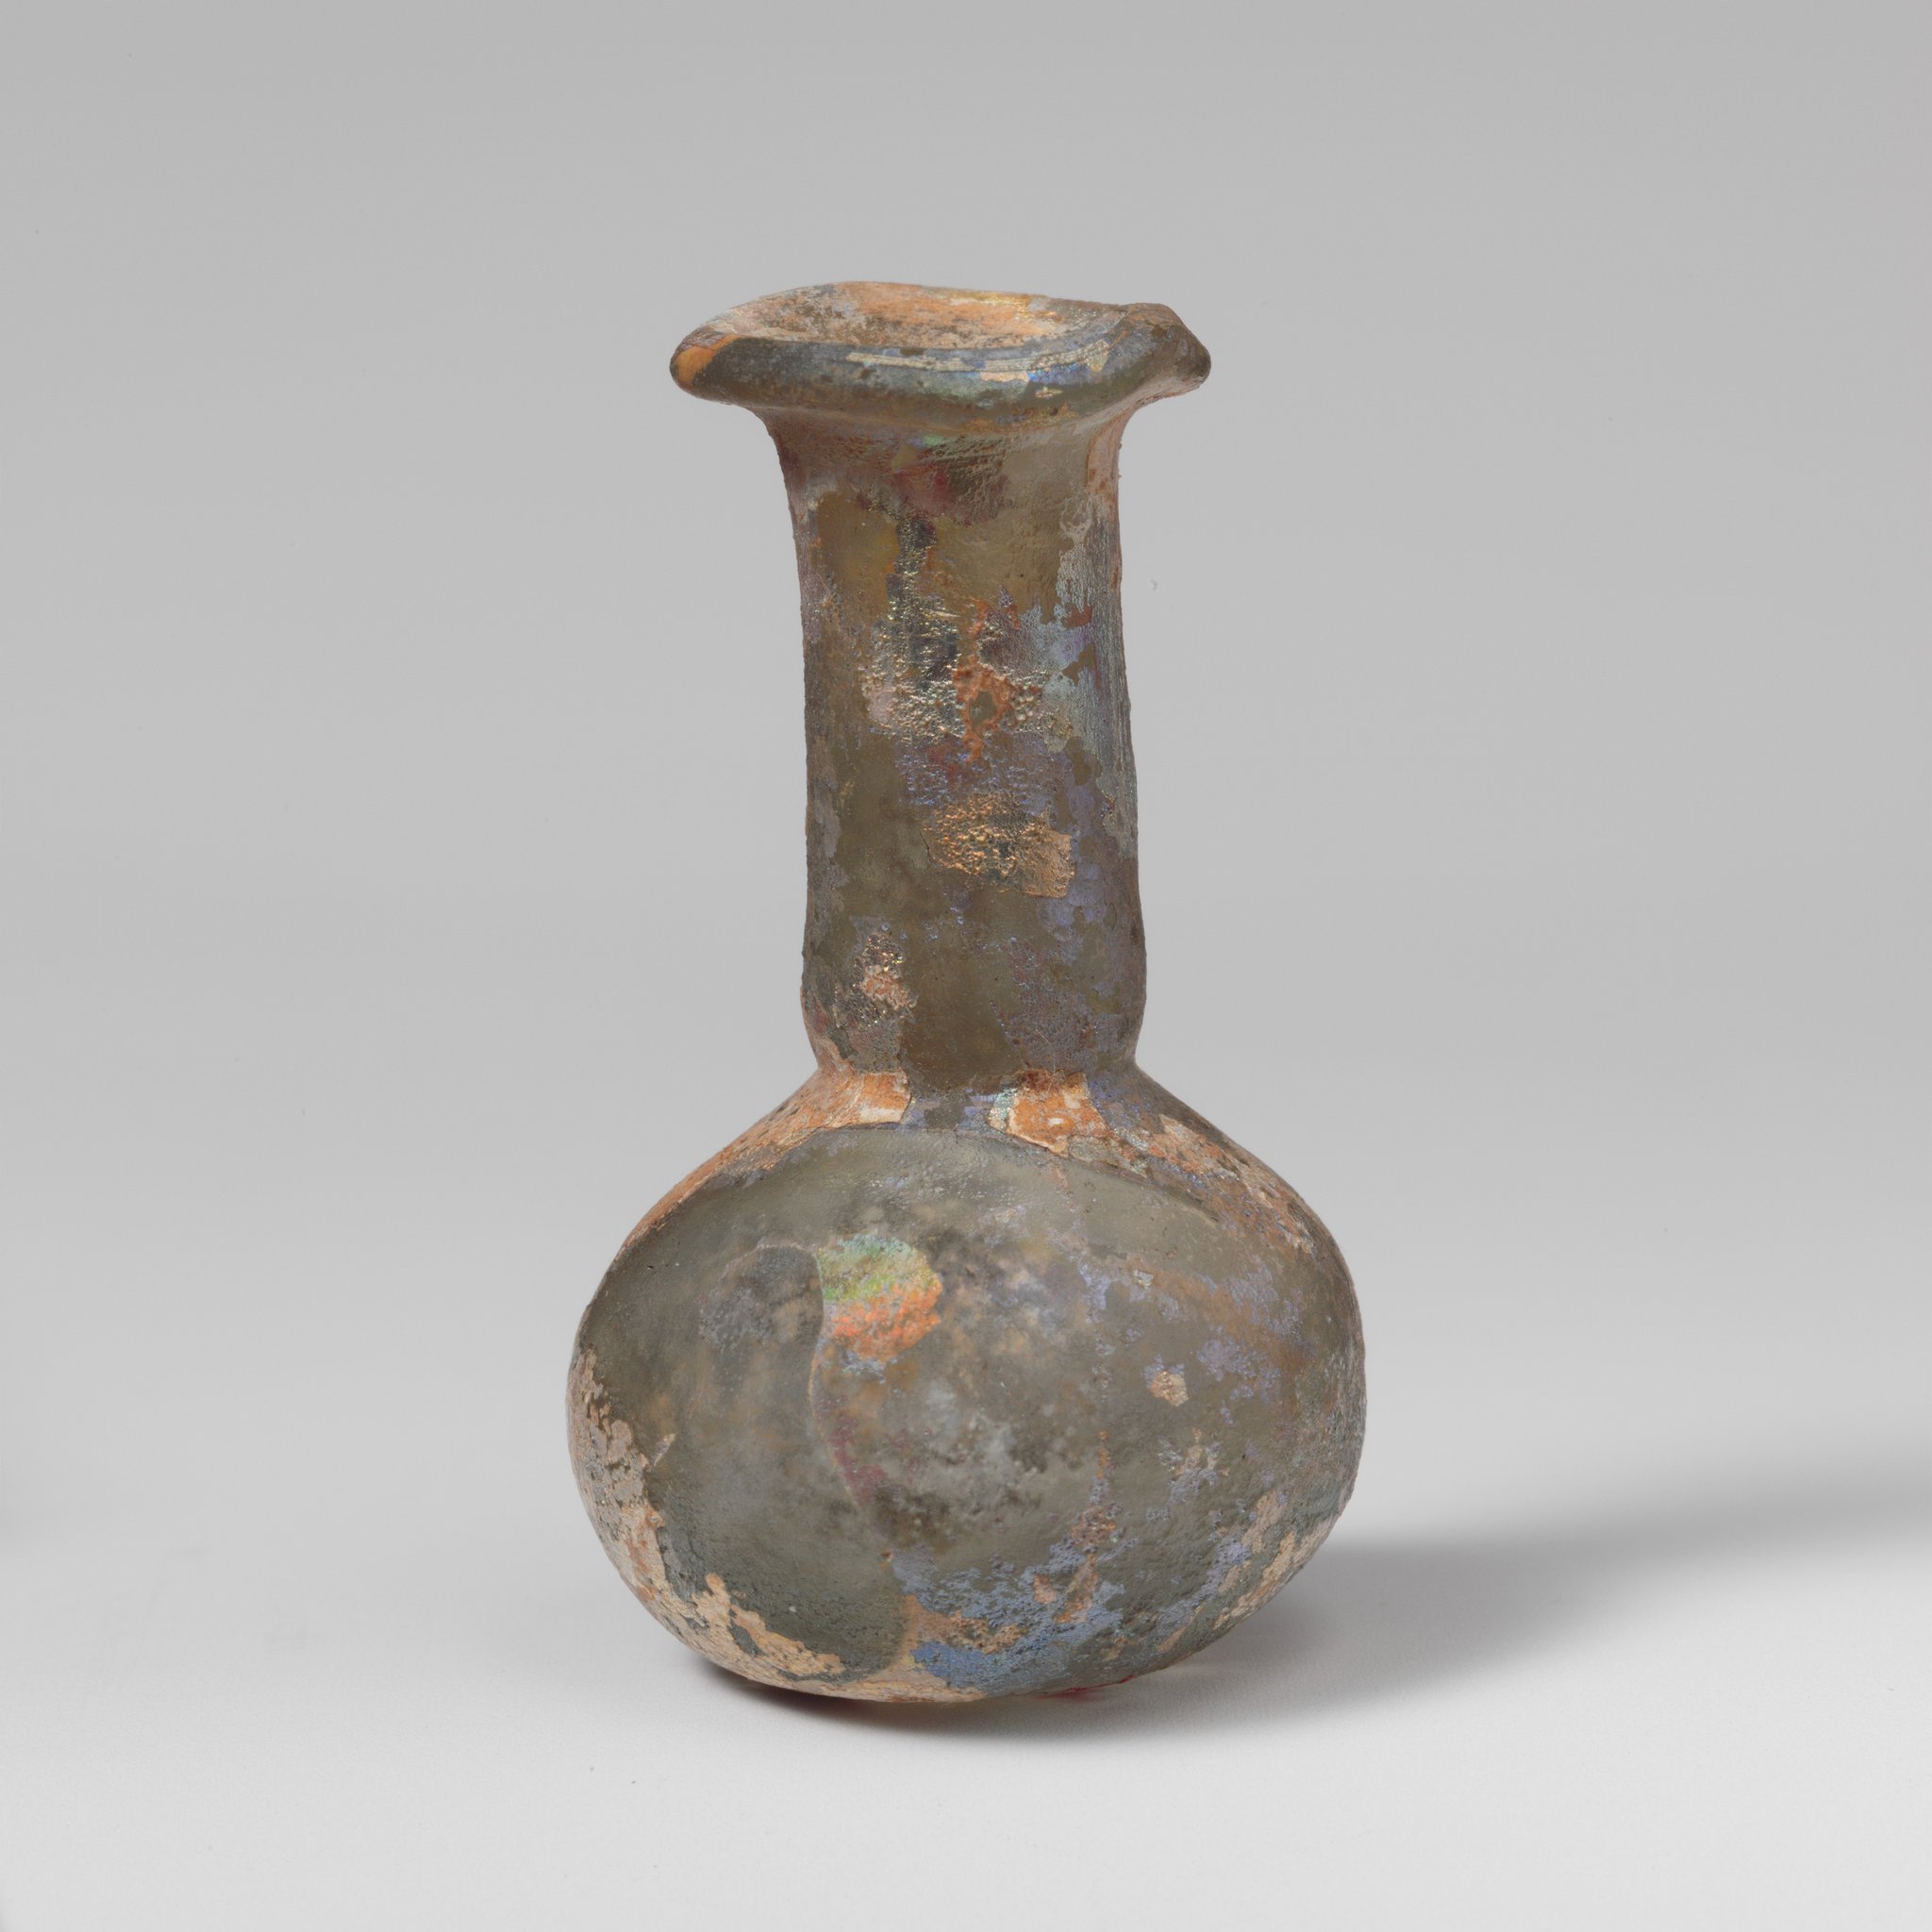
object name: perfume bottle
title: Glass perfume bottle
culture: roman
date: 1-200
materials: glass